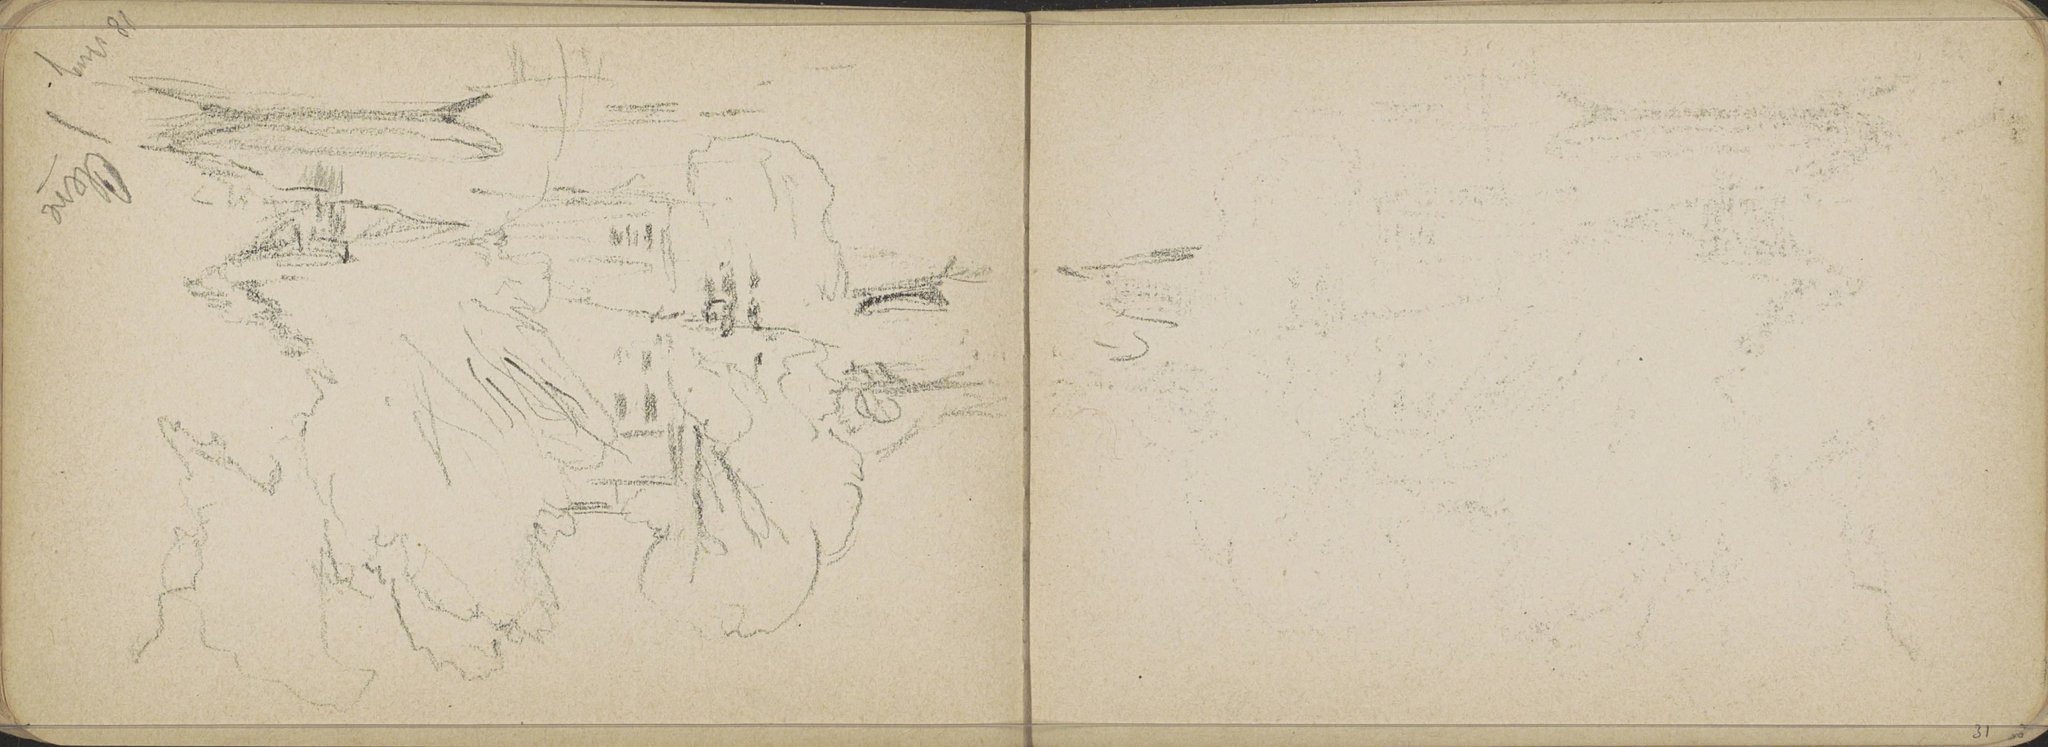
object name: sketchbook leaf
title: Gezicht op Kleef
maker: willem cornelis rip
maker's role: draughtsman, painter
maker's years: 1856-1922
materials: chalk, paper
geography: cleves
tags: city-view, and landscape with man-made constructions, landscapes with waters, waterscapes, seascapes (in the temperate zone), cleves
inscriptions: date and inscription: ‘Cleve/ 18 Aug’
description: Blad 30 verso en 31 recto uit een schetsboek met 44 bladen.